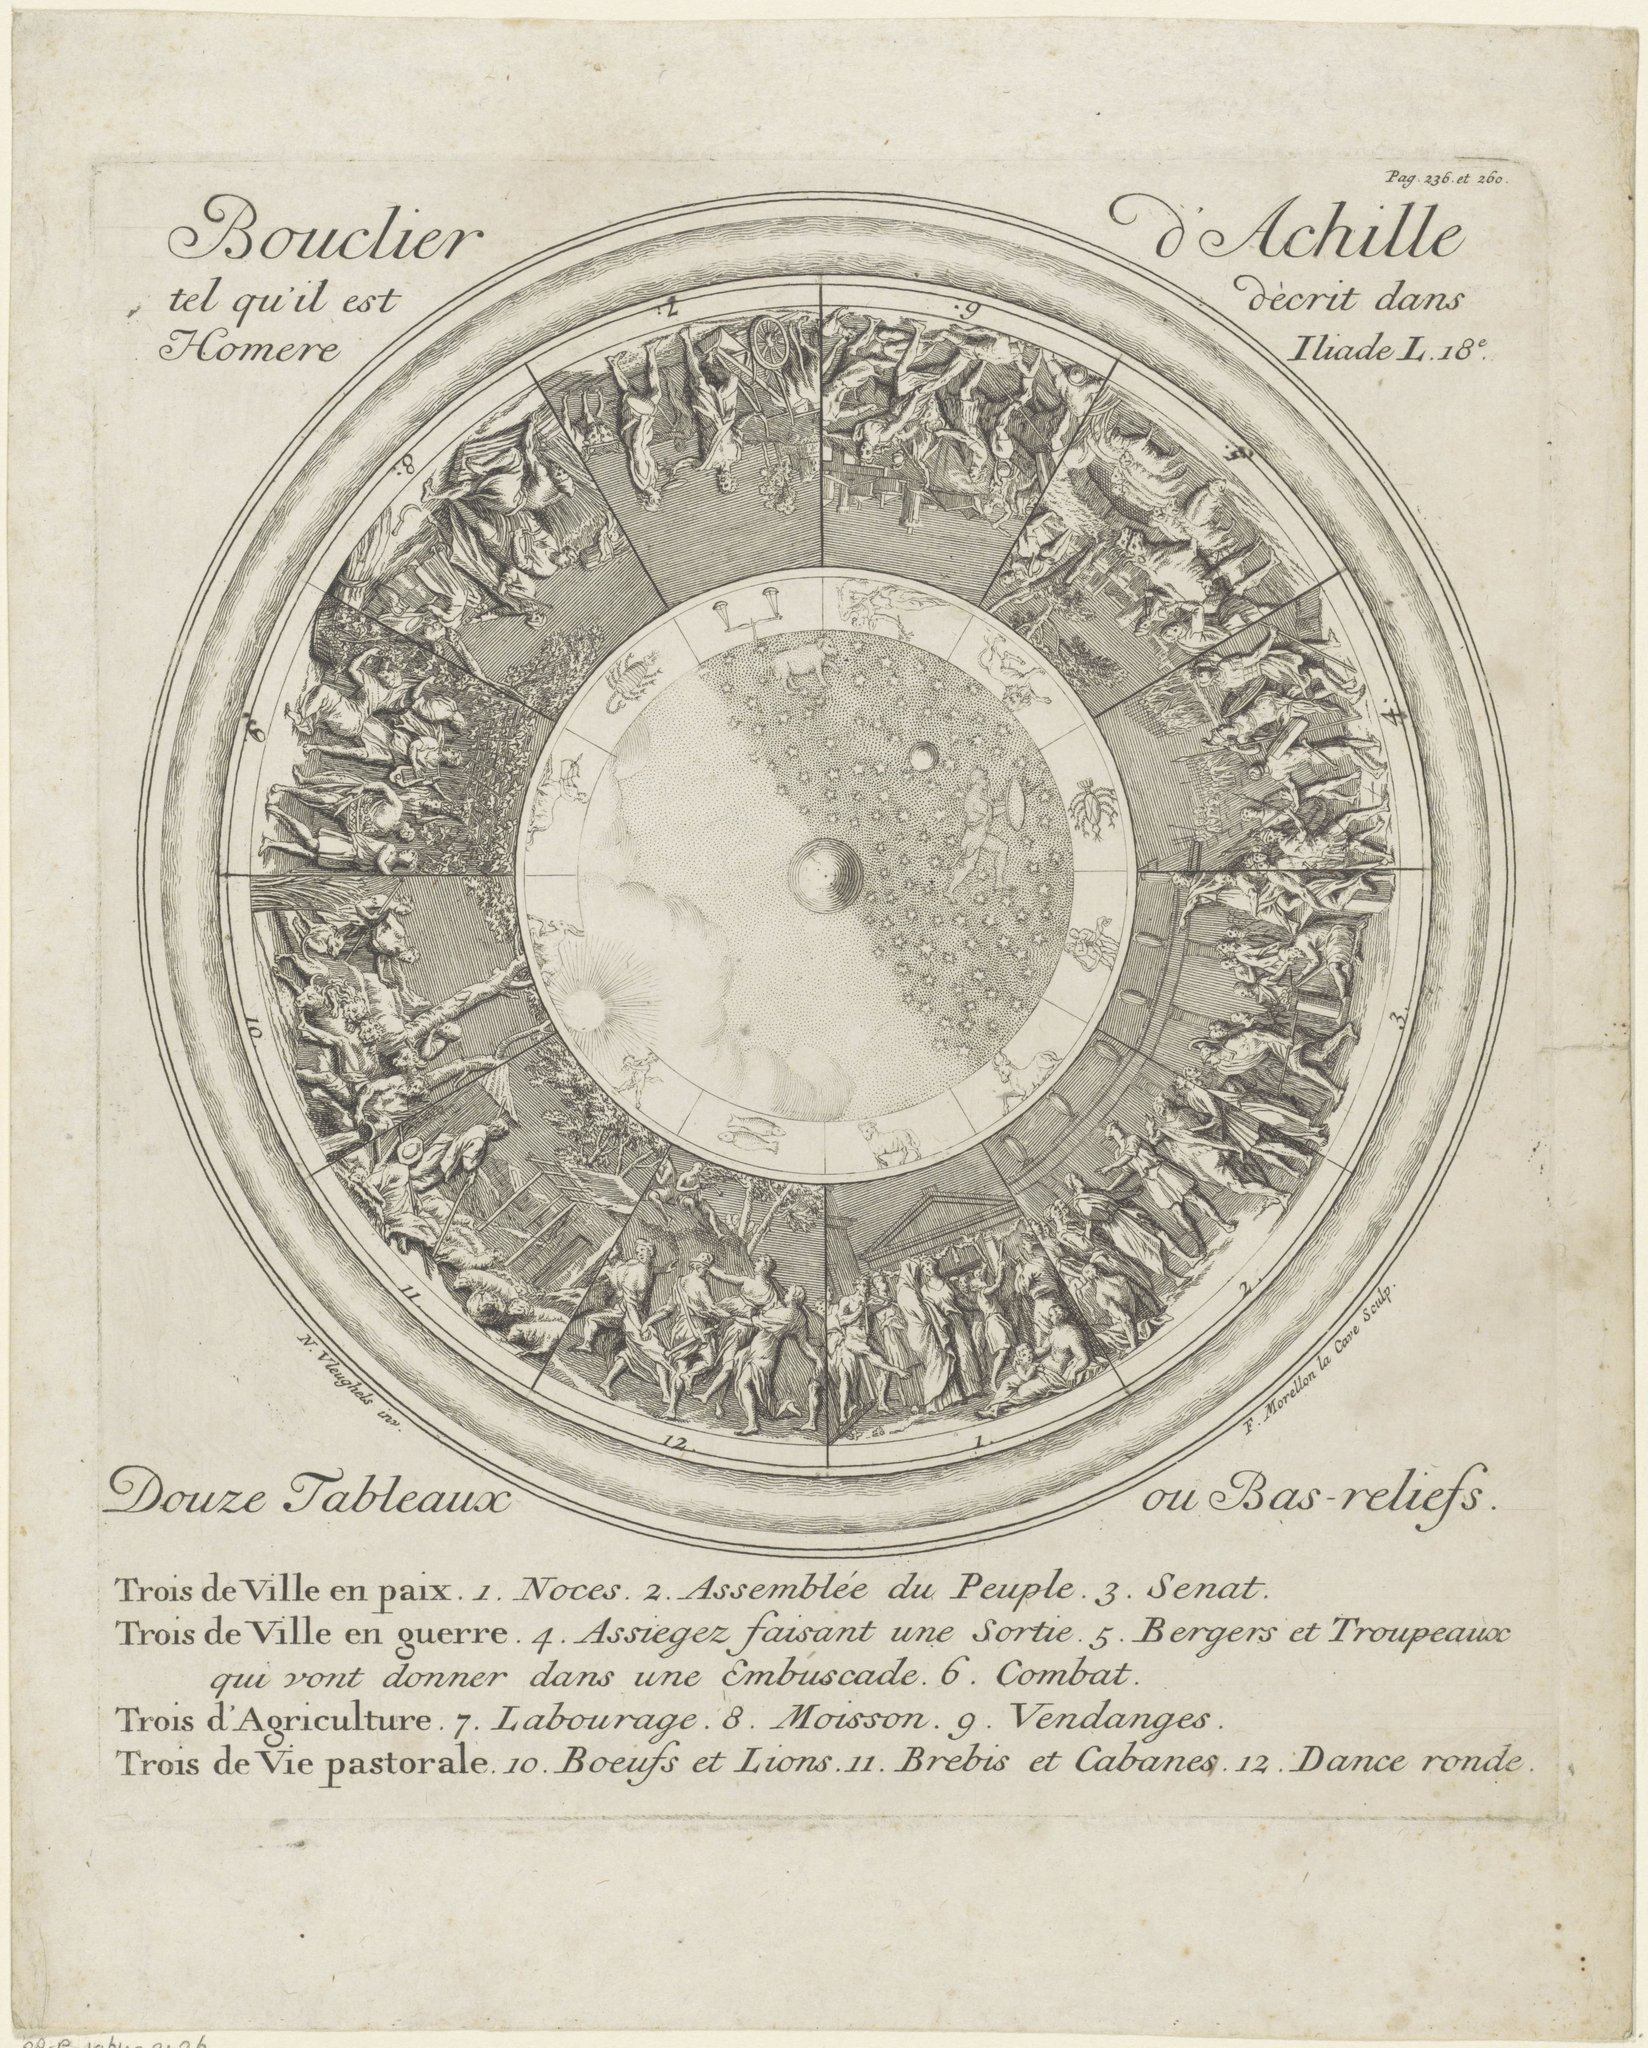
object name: book illustration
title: Schild van Achilles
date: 1706-1768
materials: paper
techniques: etching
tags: the shield of achilles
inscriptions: collector's mark: Lugt 2228, collector's mark: Lugt 2760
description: Het schild van Achilles zoals beschreven door Homerus in de Illias. Rechtsboven: Pag. 236 et 260.